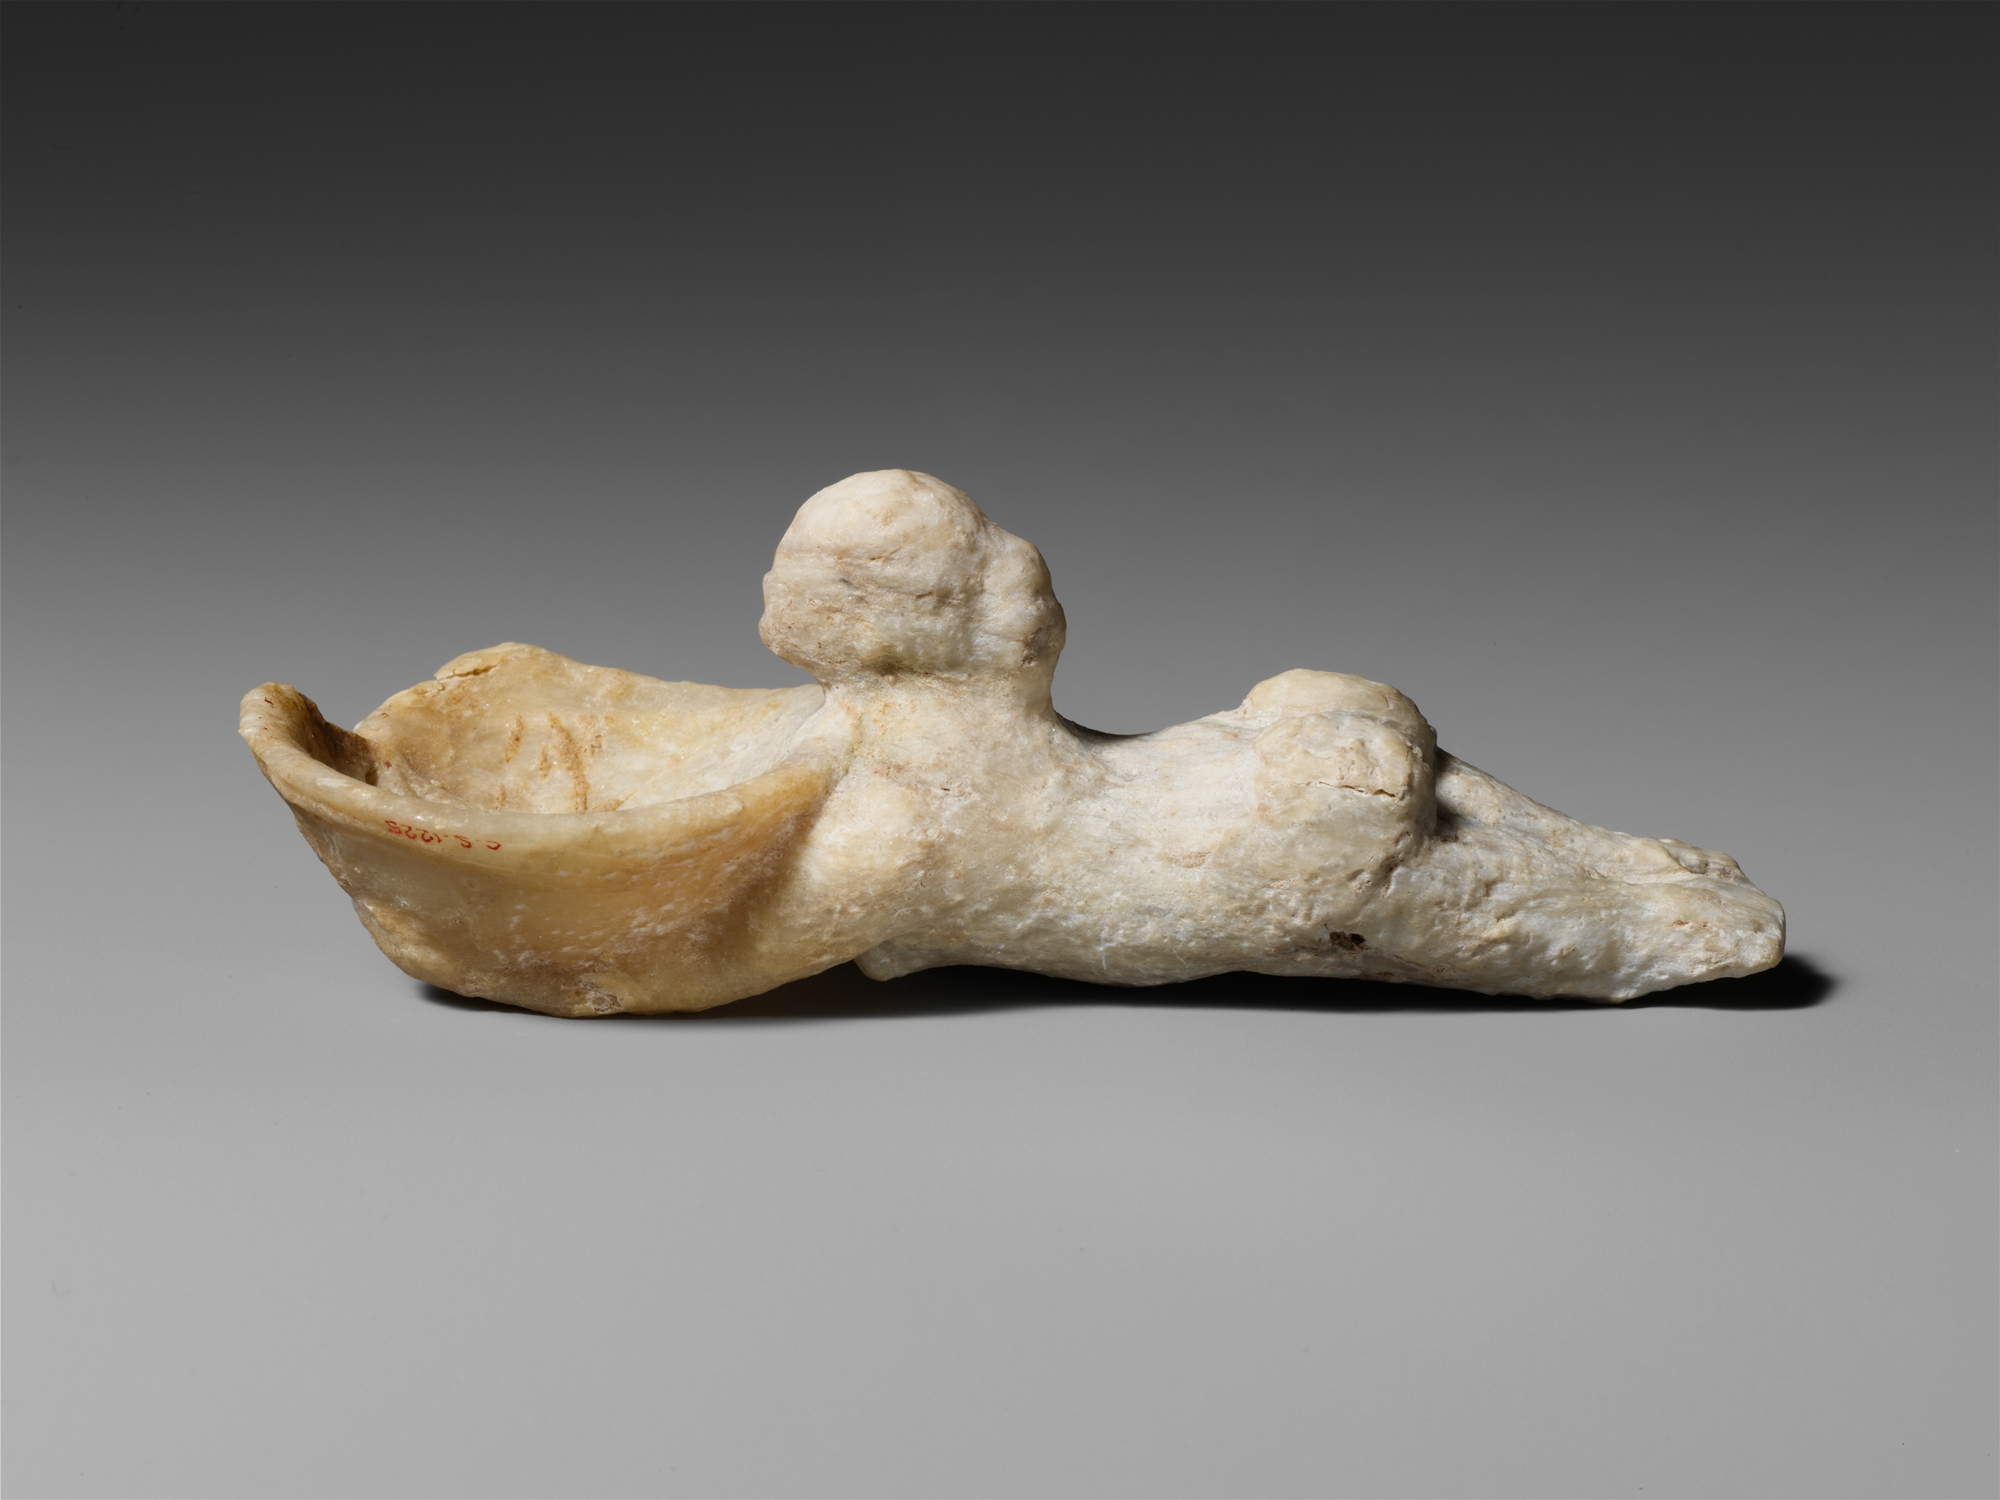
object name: spoon or ladle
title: Alabaster spoon or ladle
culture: cypriot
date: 1200-1050 BCE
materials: gypsum